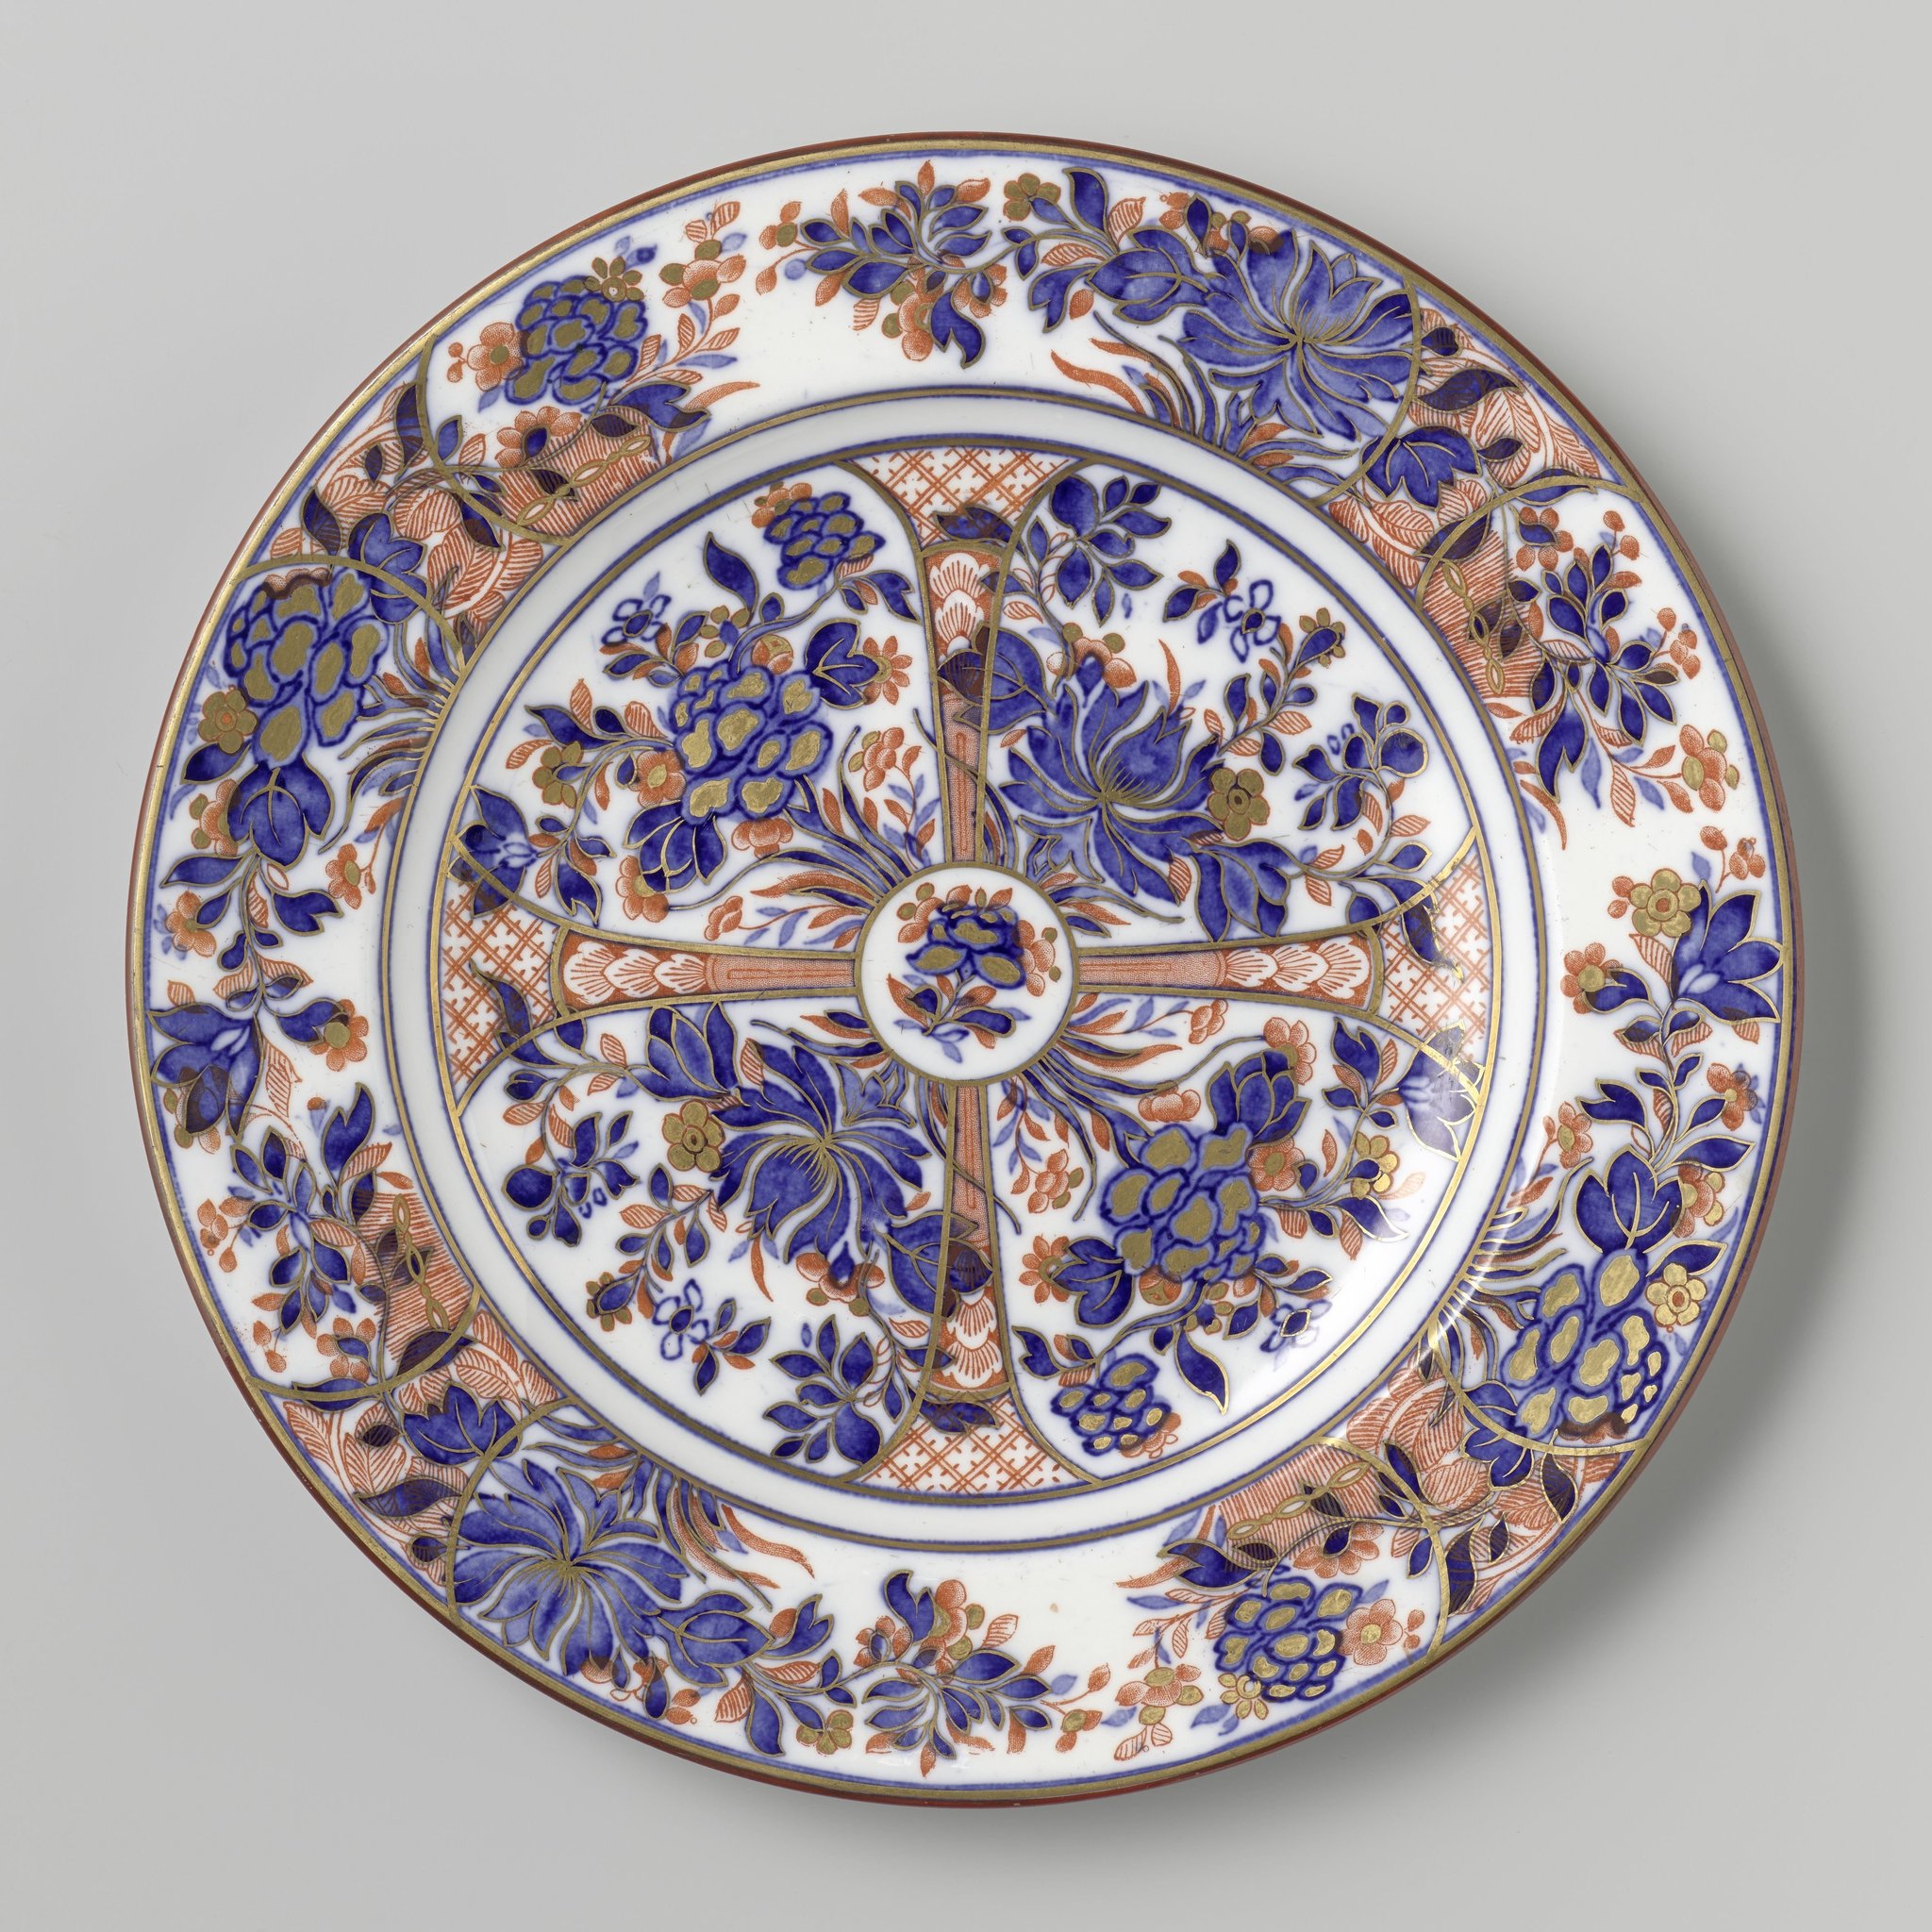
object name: plate dish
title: Bord met op het plat een kruis omgeven door bloemen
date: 1400-1950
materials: earthenware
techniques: painted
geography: england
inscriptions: check stamp: ‘WEDGWOOD’, mark: ‘WEDGWOOD’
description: Bord van aardewerk met vloeiblauw en oranje transferdecor, beschilderd met oranje en goud. Het plat is door middel van een kruis in vieren gedeeld en is gedecoreerd met bloemen. De rand van het bord is eveneens gedecoreerd met bloemen.